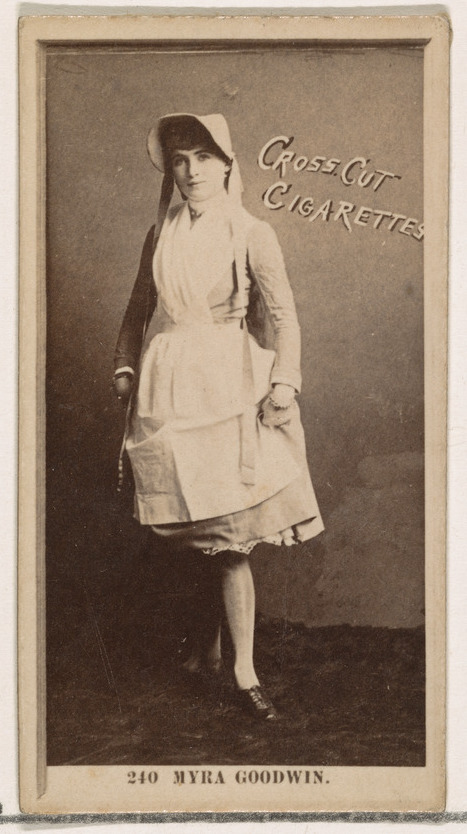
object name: print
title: Card Number 240, Myra Goodwin, from the Actors and Actresses series (N145-2) issued by Duke Sons & Co. to promote Cross Cut Cigarettes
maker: w. duke, sons & co.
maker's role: publisher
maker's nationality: american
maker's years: 1870-1920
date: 1880-1889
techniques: albumen silver print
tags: portraits,women,actresses